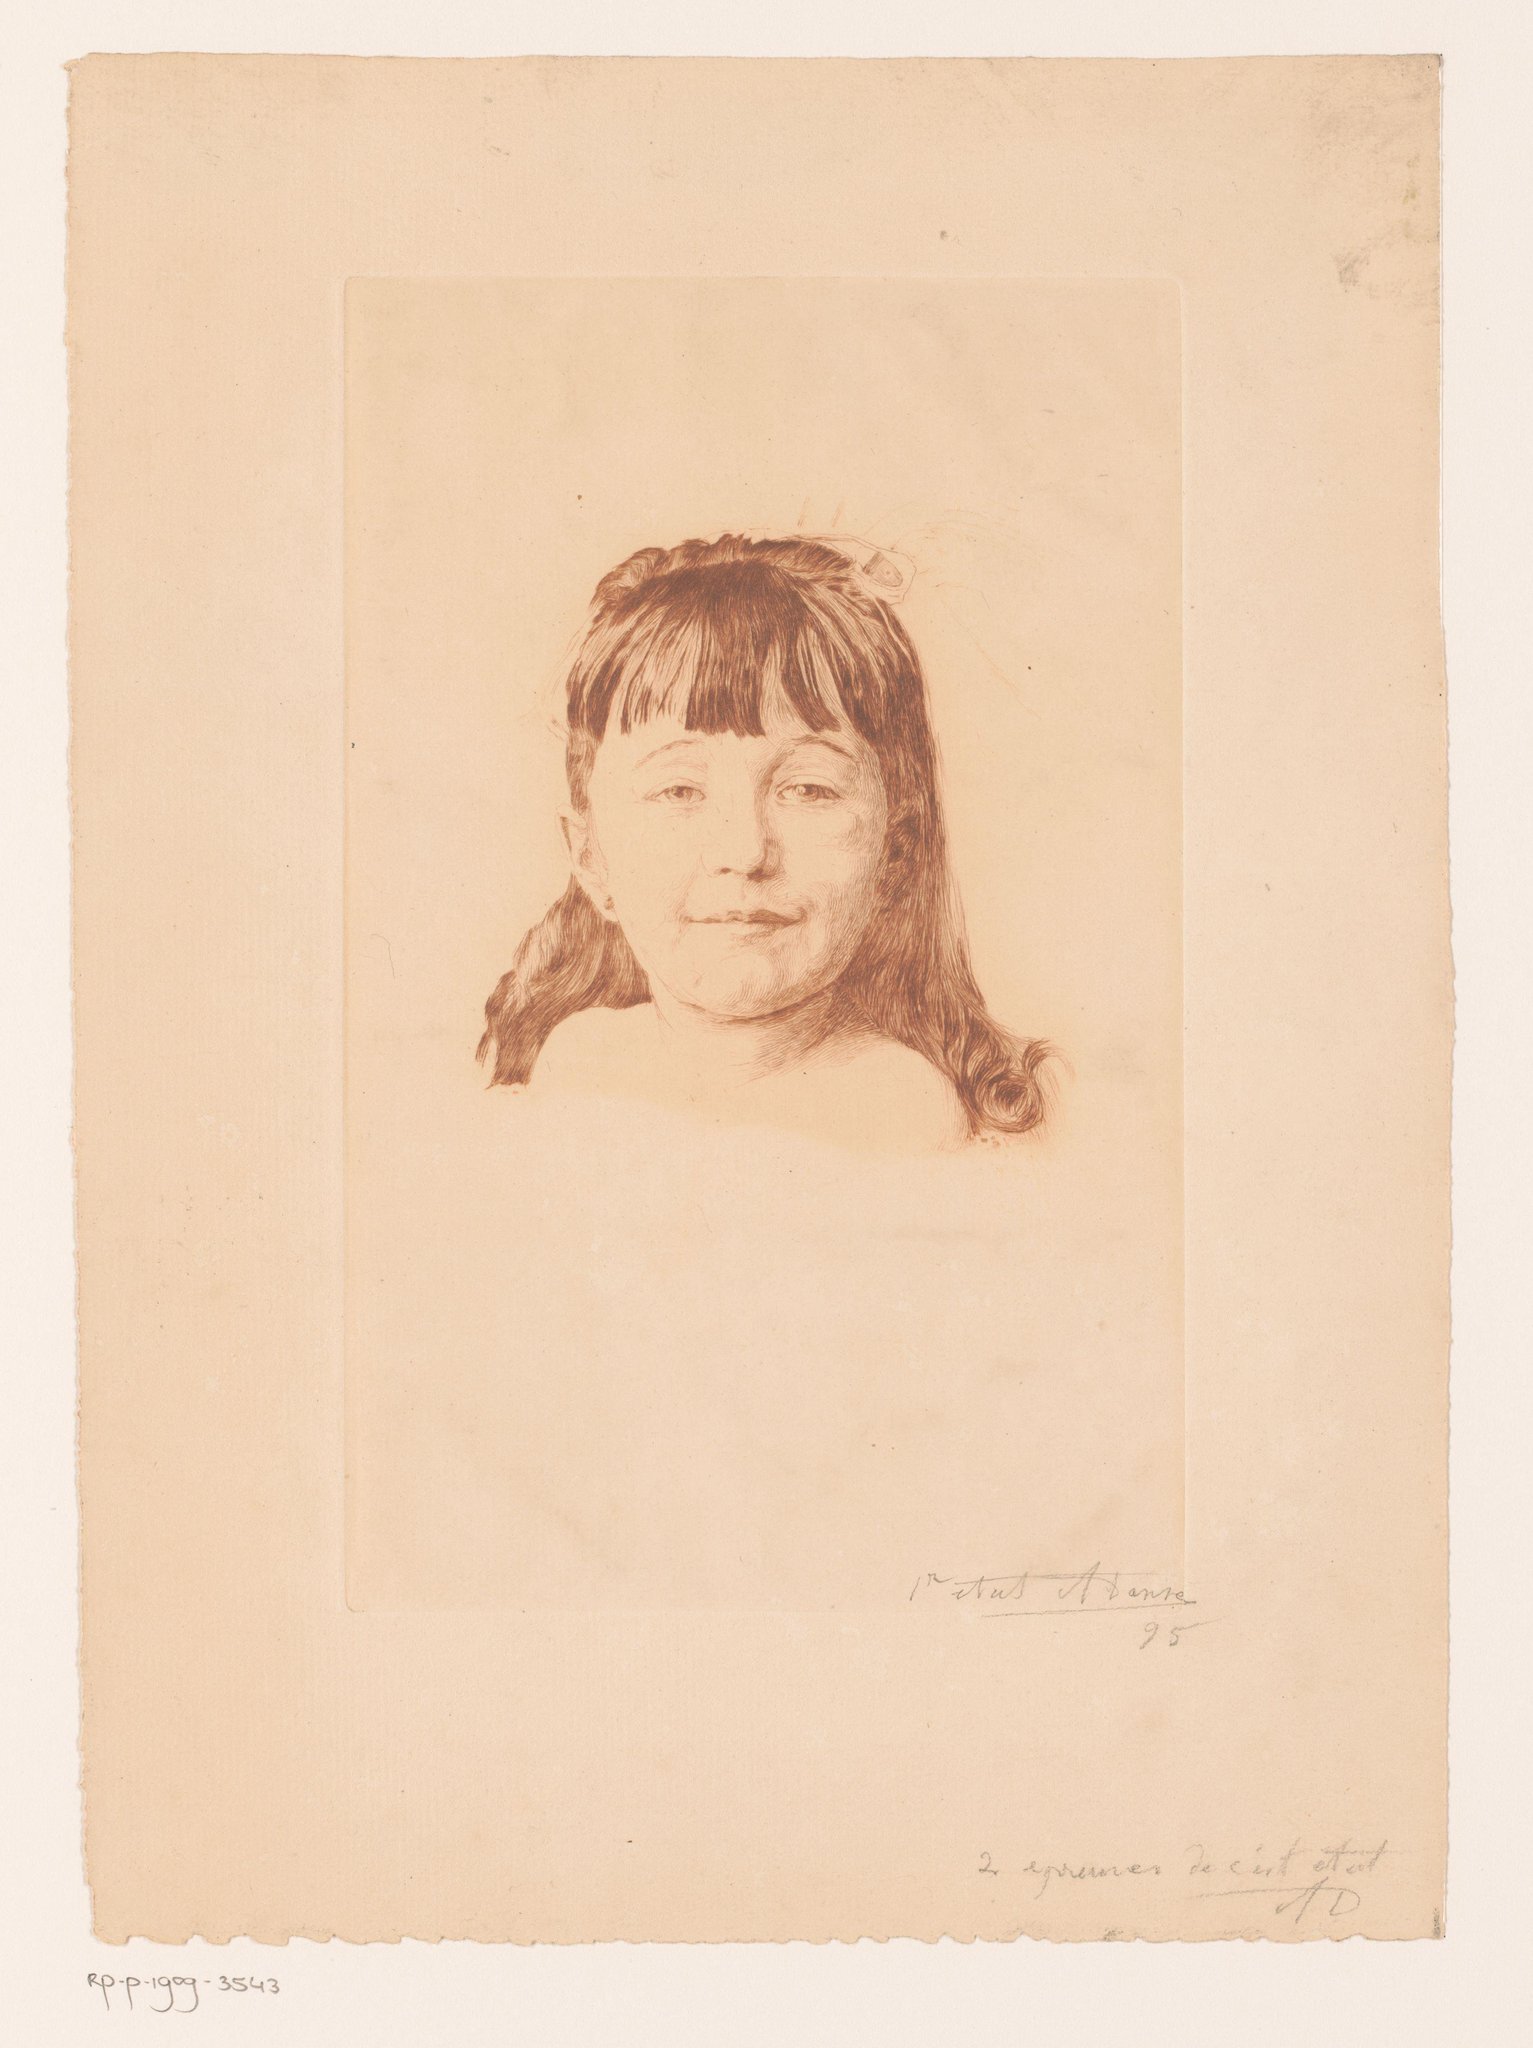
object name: print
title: Portret van een onbekend meisje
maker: auguste danse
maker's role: print maker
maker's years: 1829-1929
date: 1895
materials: paper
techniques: drypoint, etching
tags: adolescent, young woman, maiden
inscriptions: annotation: ‘1er etat; 2 epreuves de c'est etat’, watermark: ‘Van Gelder Zonen’, collector's mark: Lugt 2228